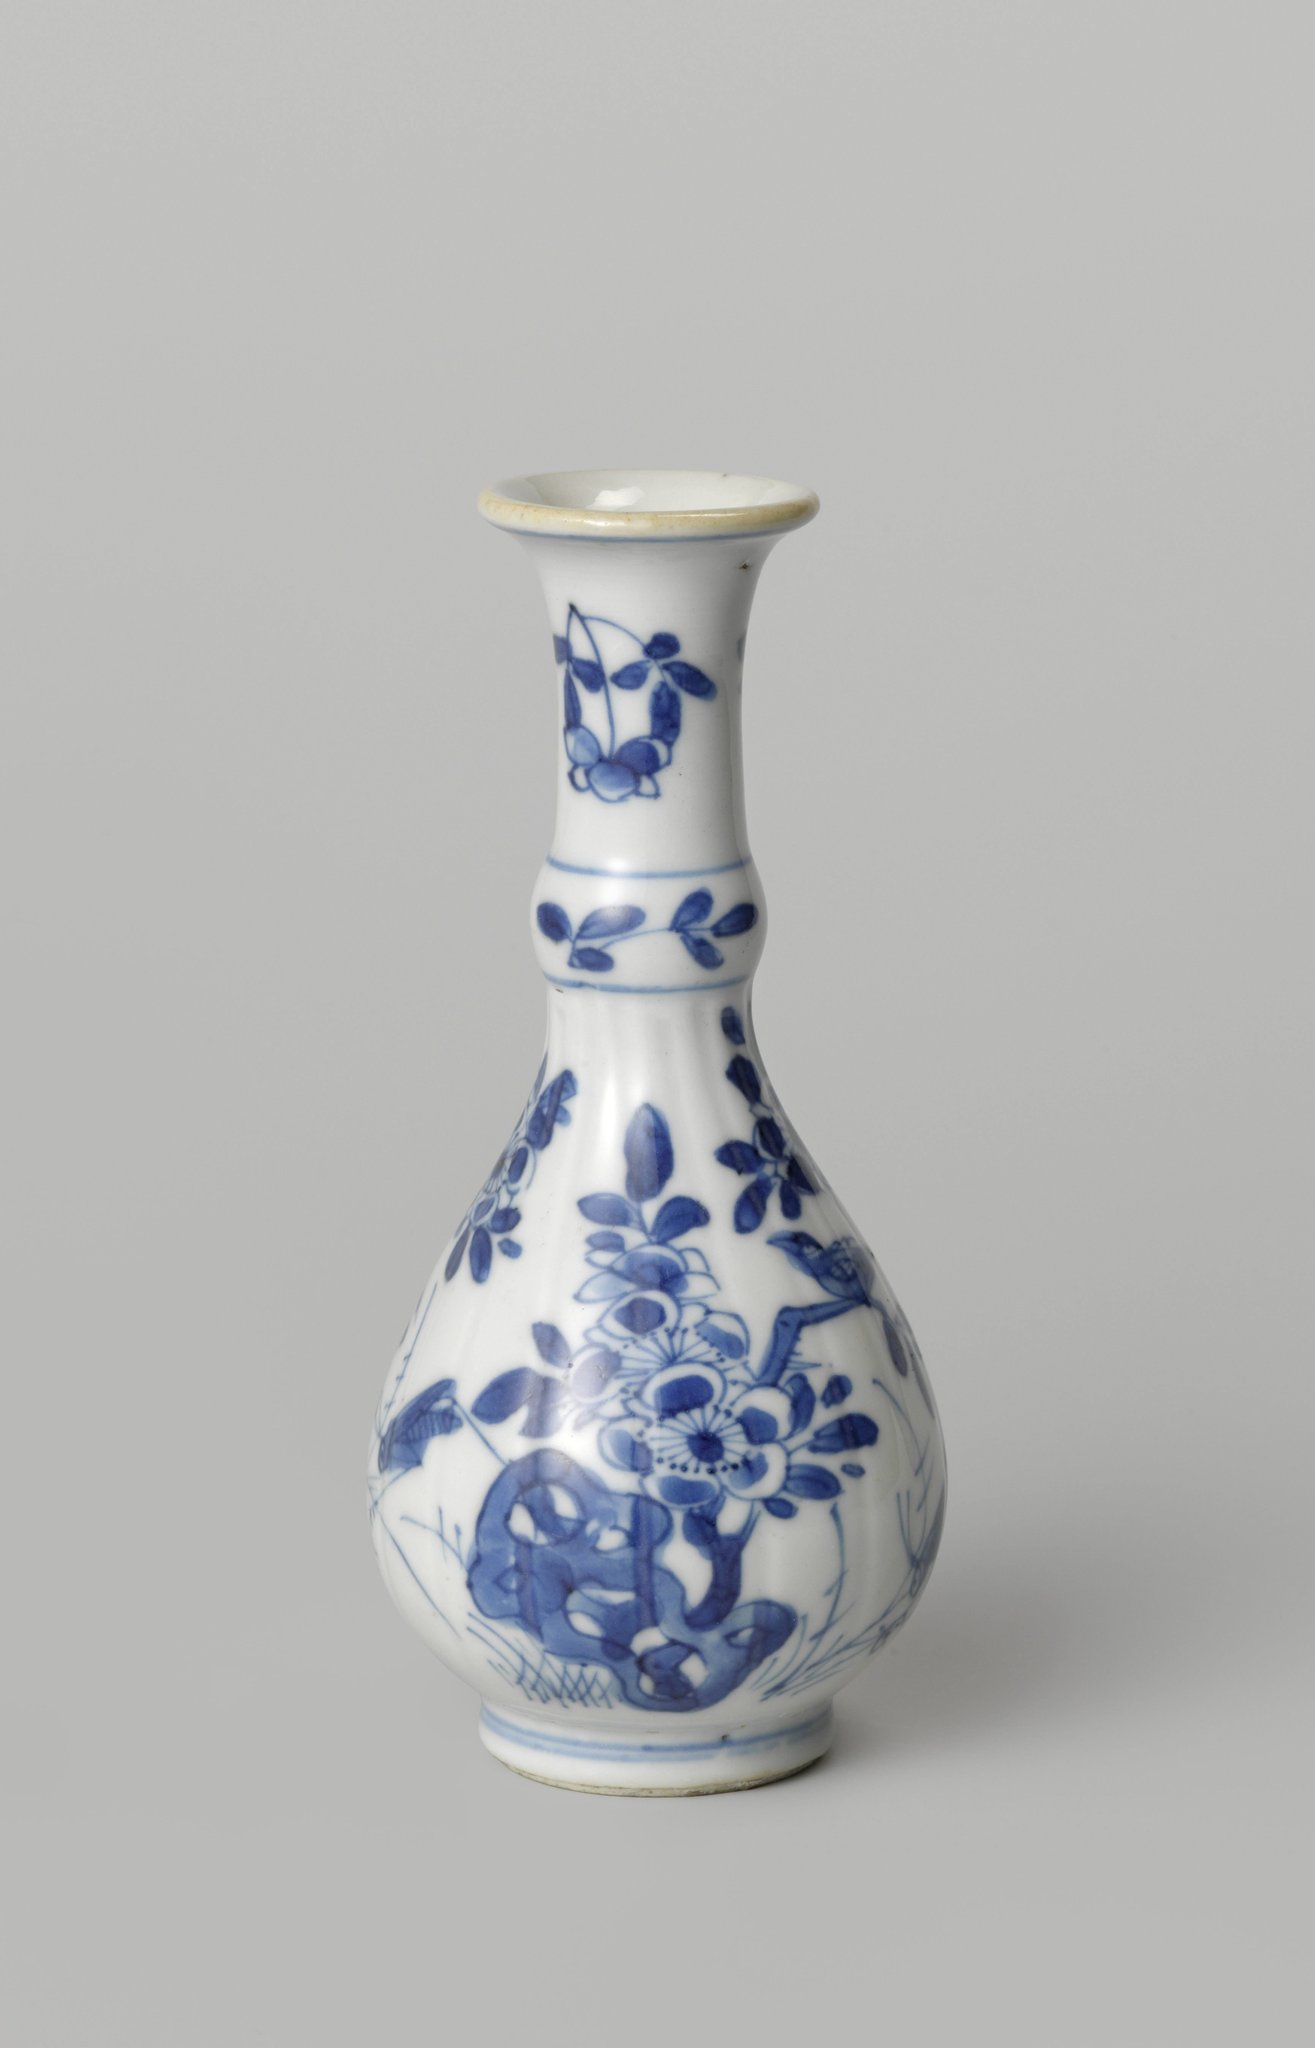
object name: vase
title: Pear-shaped bottle vase with flowering plants, birds and insects near a rock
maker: Anonymous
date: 1680-1720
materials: cobalt, glaze, paint, porcelain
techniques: firing, forming, turning, vitrification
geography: china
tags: birds, ornament derived from plant forms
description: Flesvormige vaas van porselein met een geribd, peervormig lichaam, ringvormige verdikking in de nek, aan de bovenkant spreidend, beschilderd in onderglazuur blauw. Op de buik een bloeiende plant met vogels en insecten bij een rots. De ringvormige verdikking en de nek met bloemtakken. Blauw-wit.